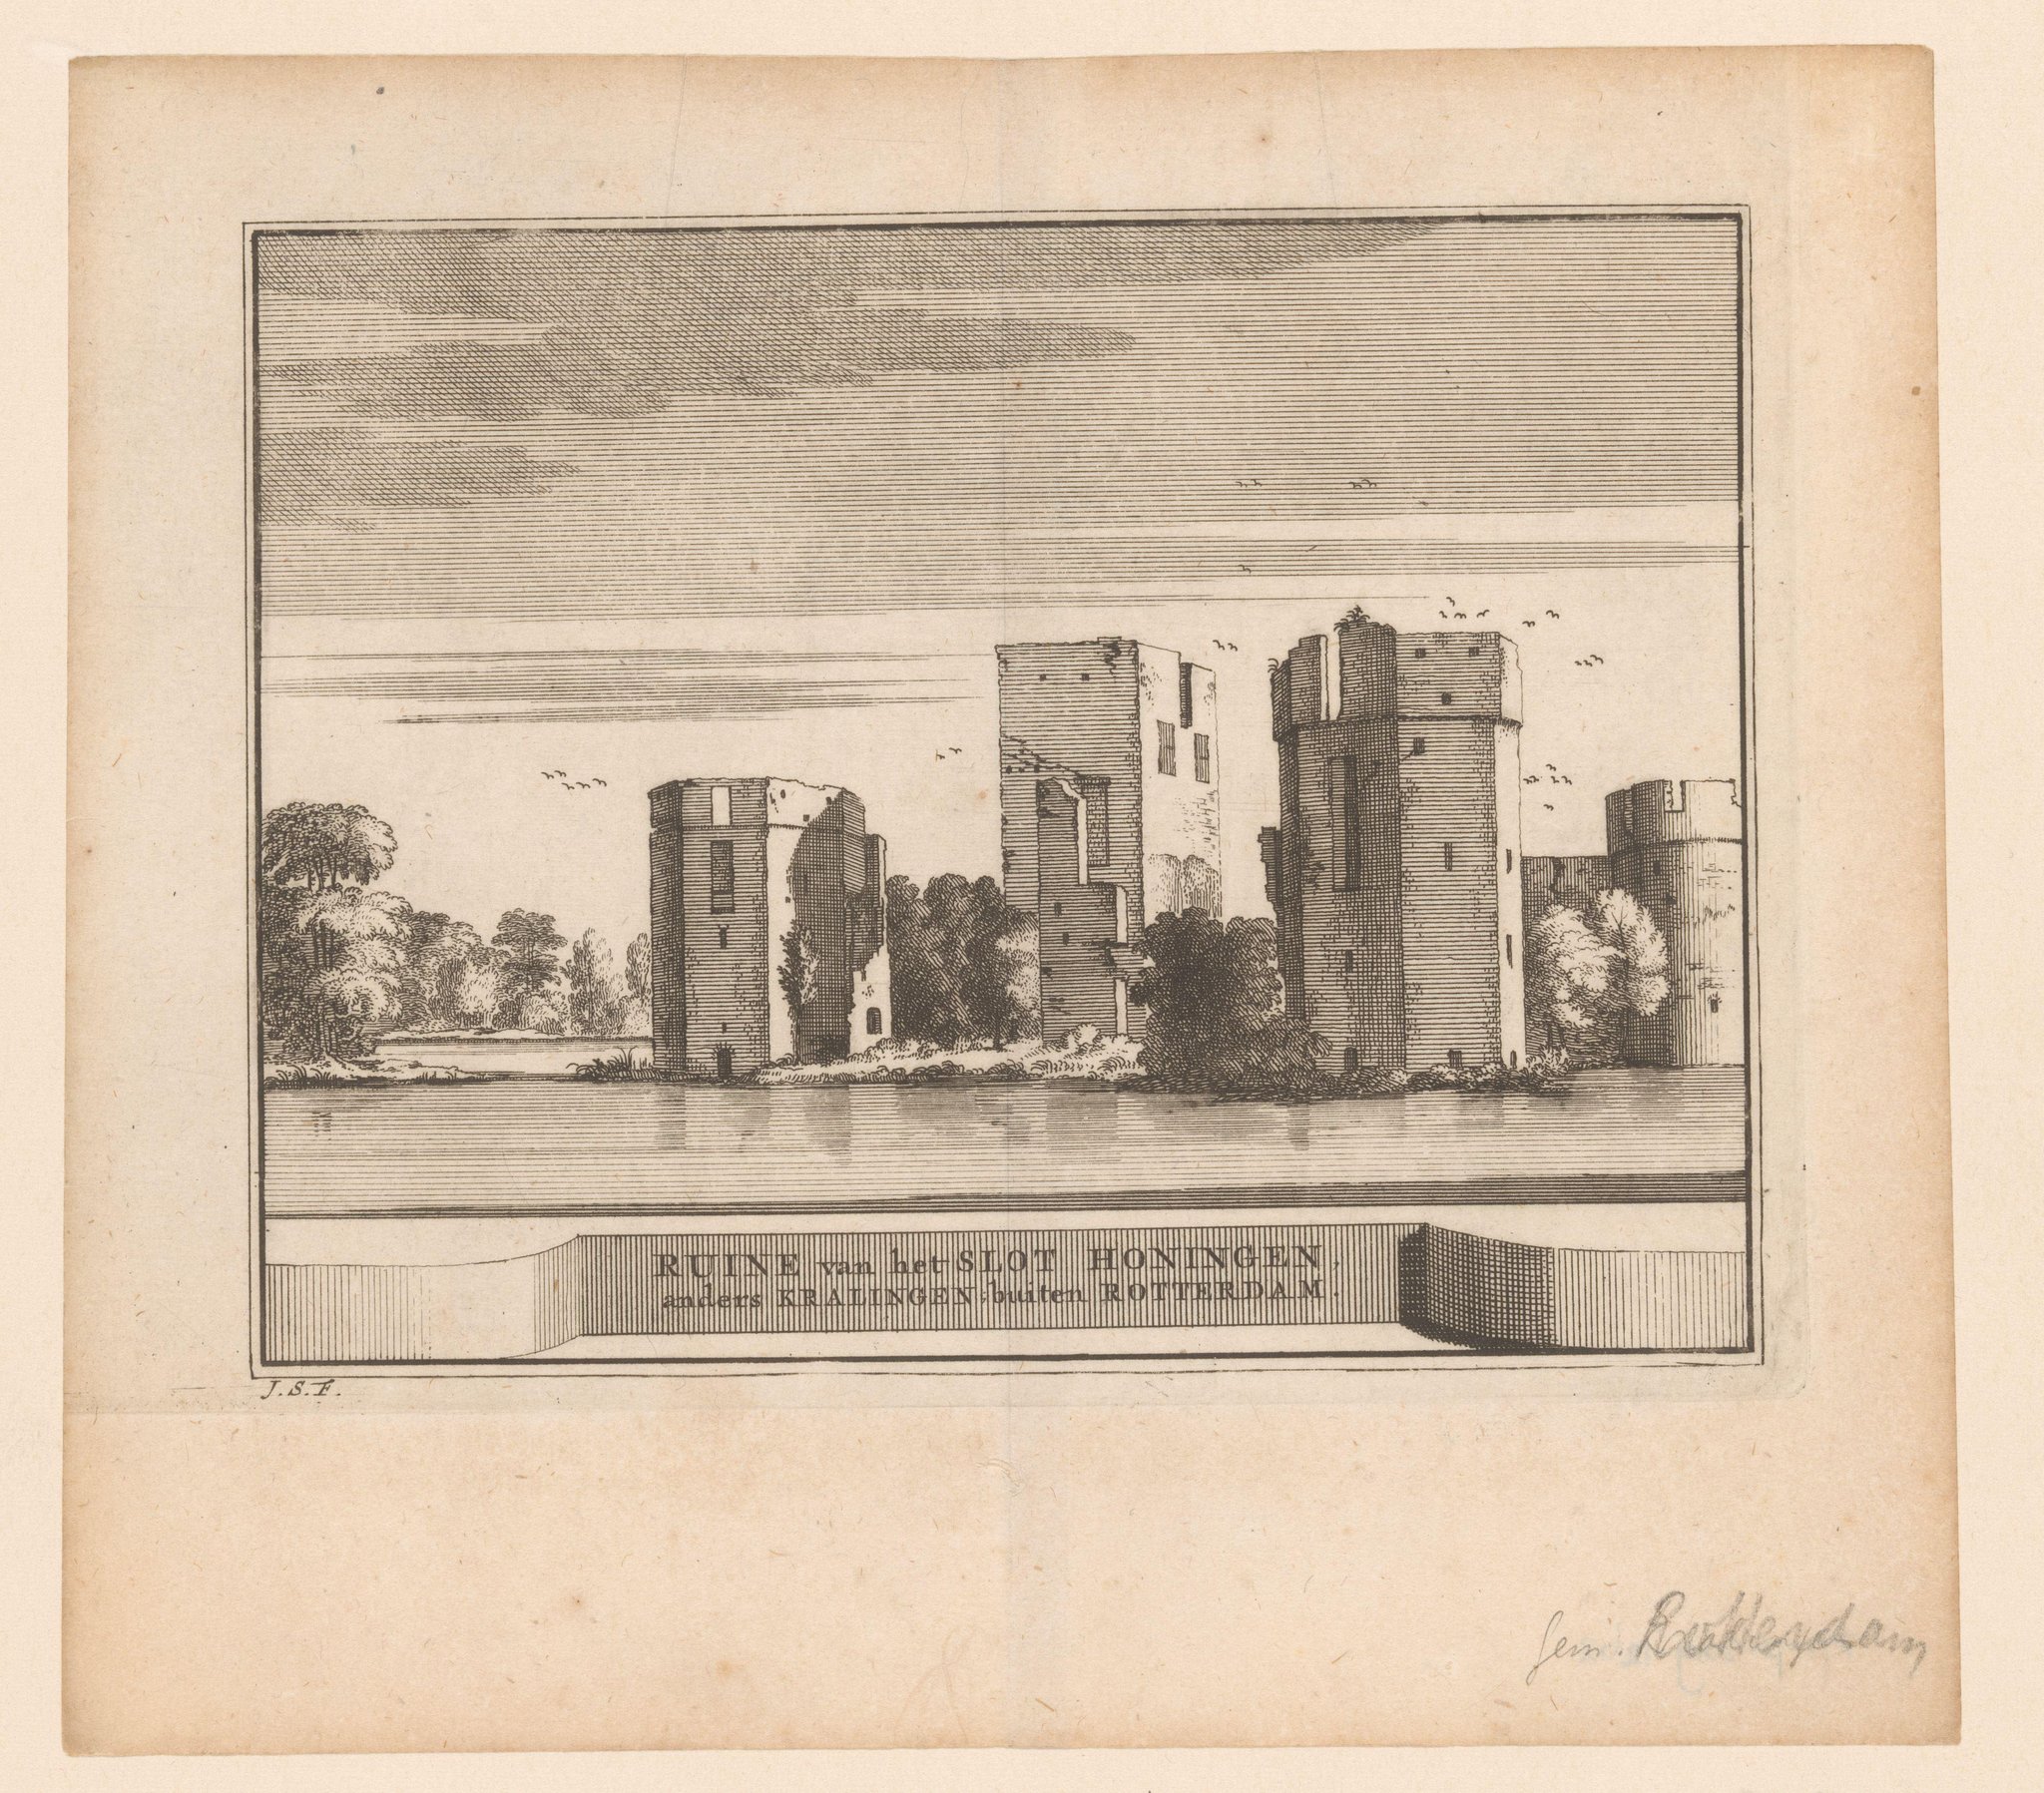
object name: book illustration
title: Ruine van het slot Honingen anders Kralingen buiten Rotterdam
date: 1711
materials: paper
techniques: engraving, etching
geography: amsterdam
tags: castle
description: Prent uit: Smids, Ludolf. Schatkamer der Nederlandsse oudheden (...). Amsterdam: Pieter de Coup, 1711, p. 144-145.